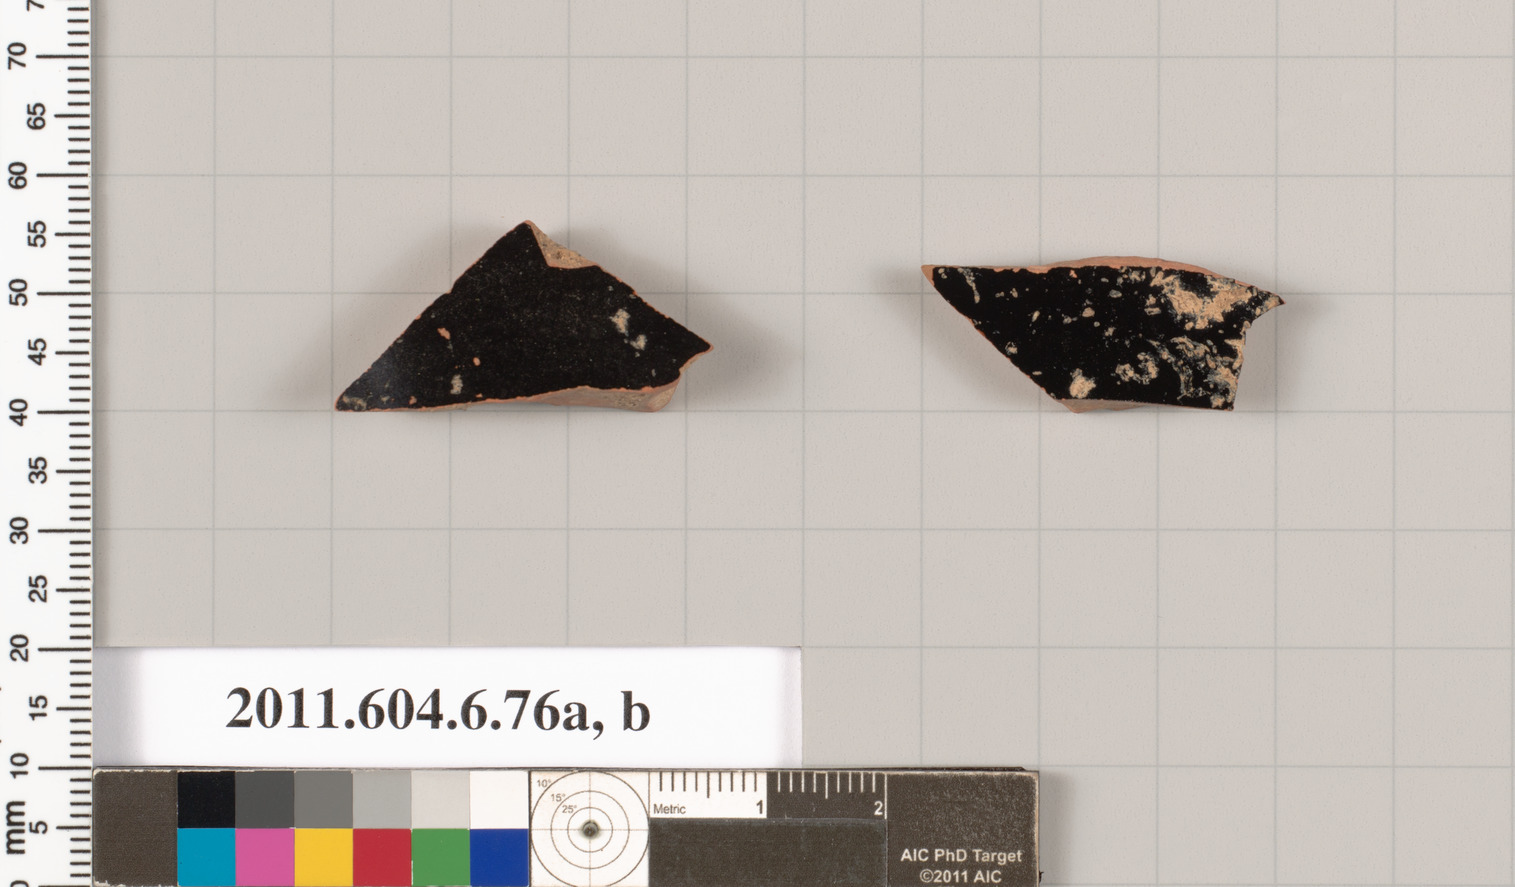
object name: undetermined open shape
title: Terracotta fragments of open shapes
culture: greek, attic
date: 600-401 BCE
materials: terracotta